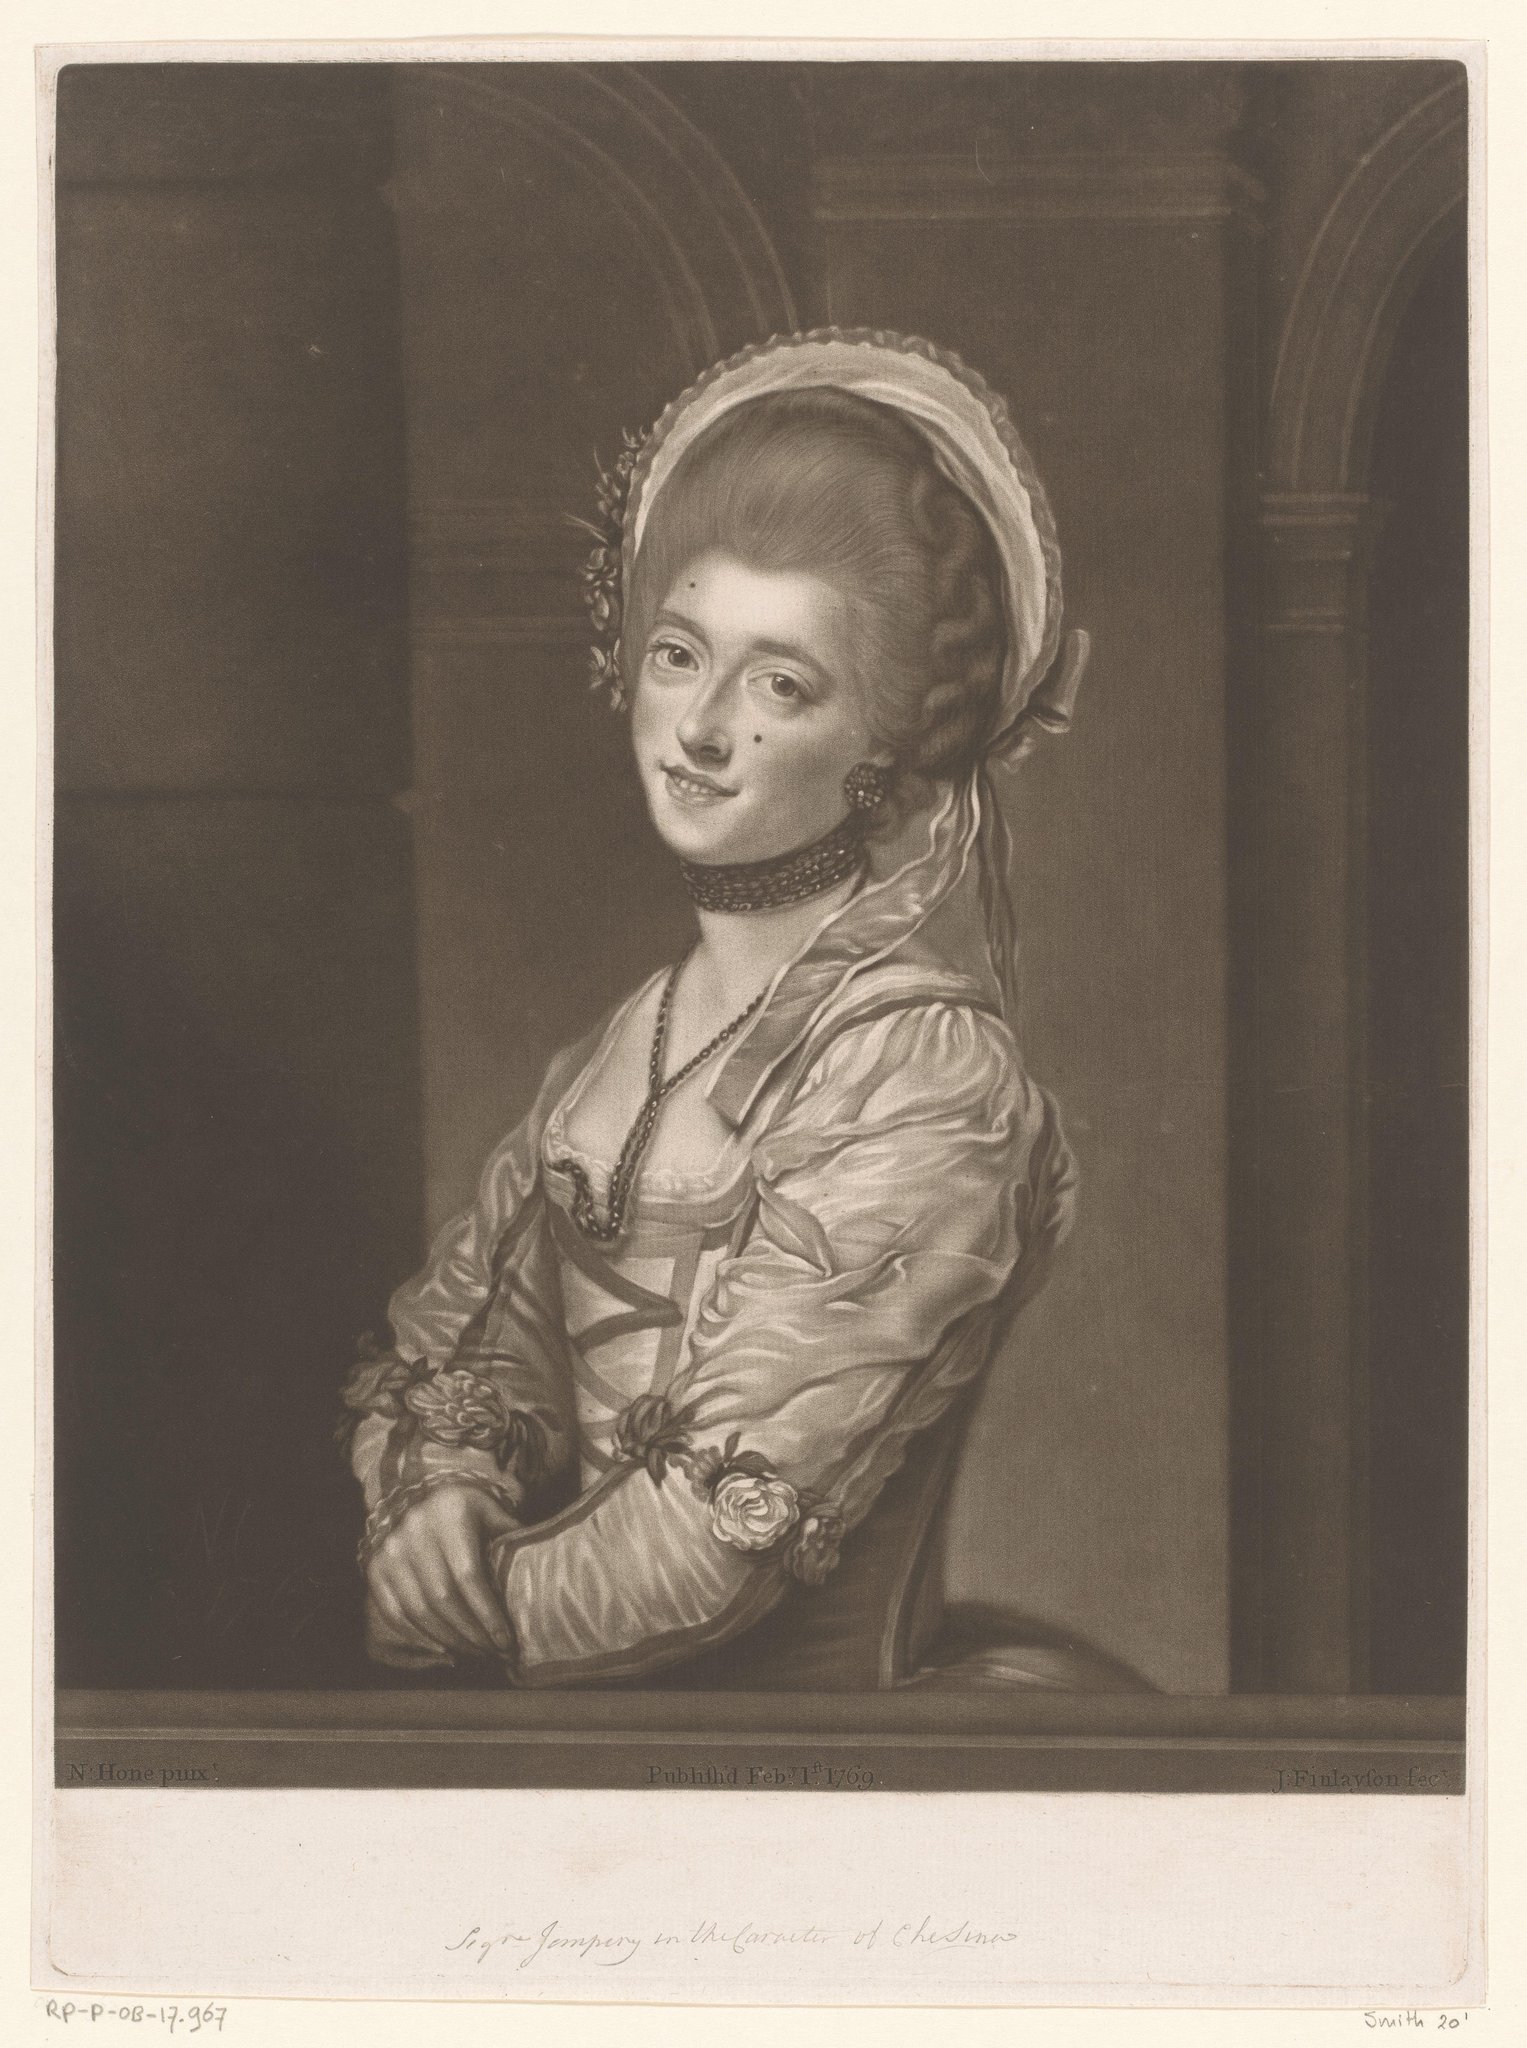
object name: print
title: Portret van Anna Zamperini als Cecchina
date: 1702-1769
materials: paper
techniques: mezzotint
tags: historical persons - bb - woman, portrait of opera-singer, female literary characters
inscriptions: collector's mark: Lugt 240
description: Zamperini als Cecchina uit de opera 'La buona figliuola'.